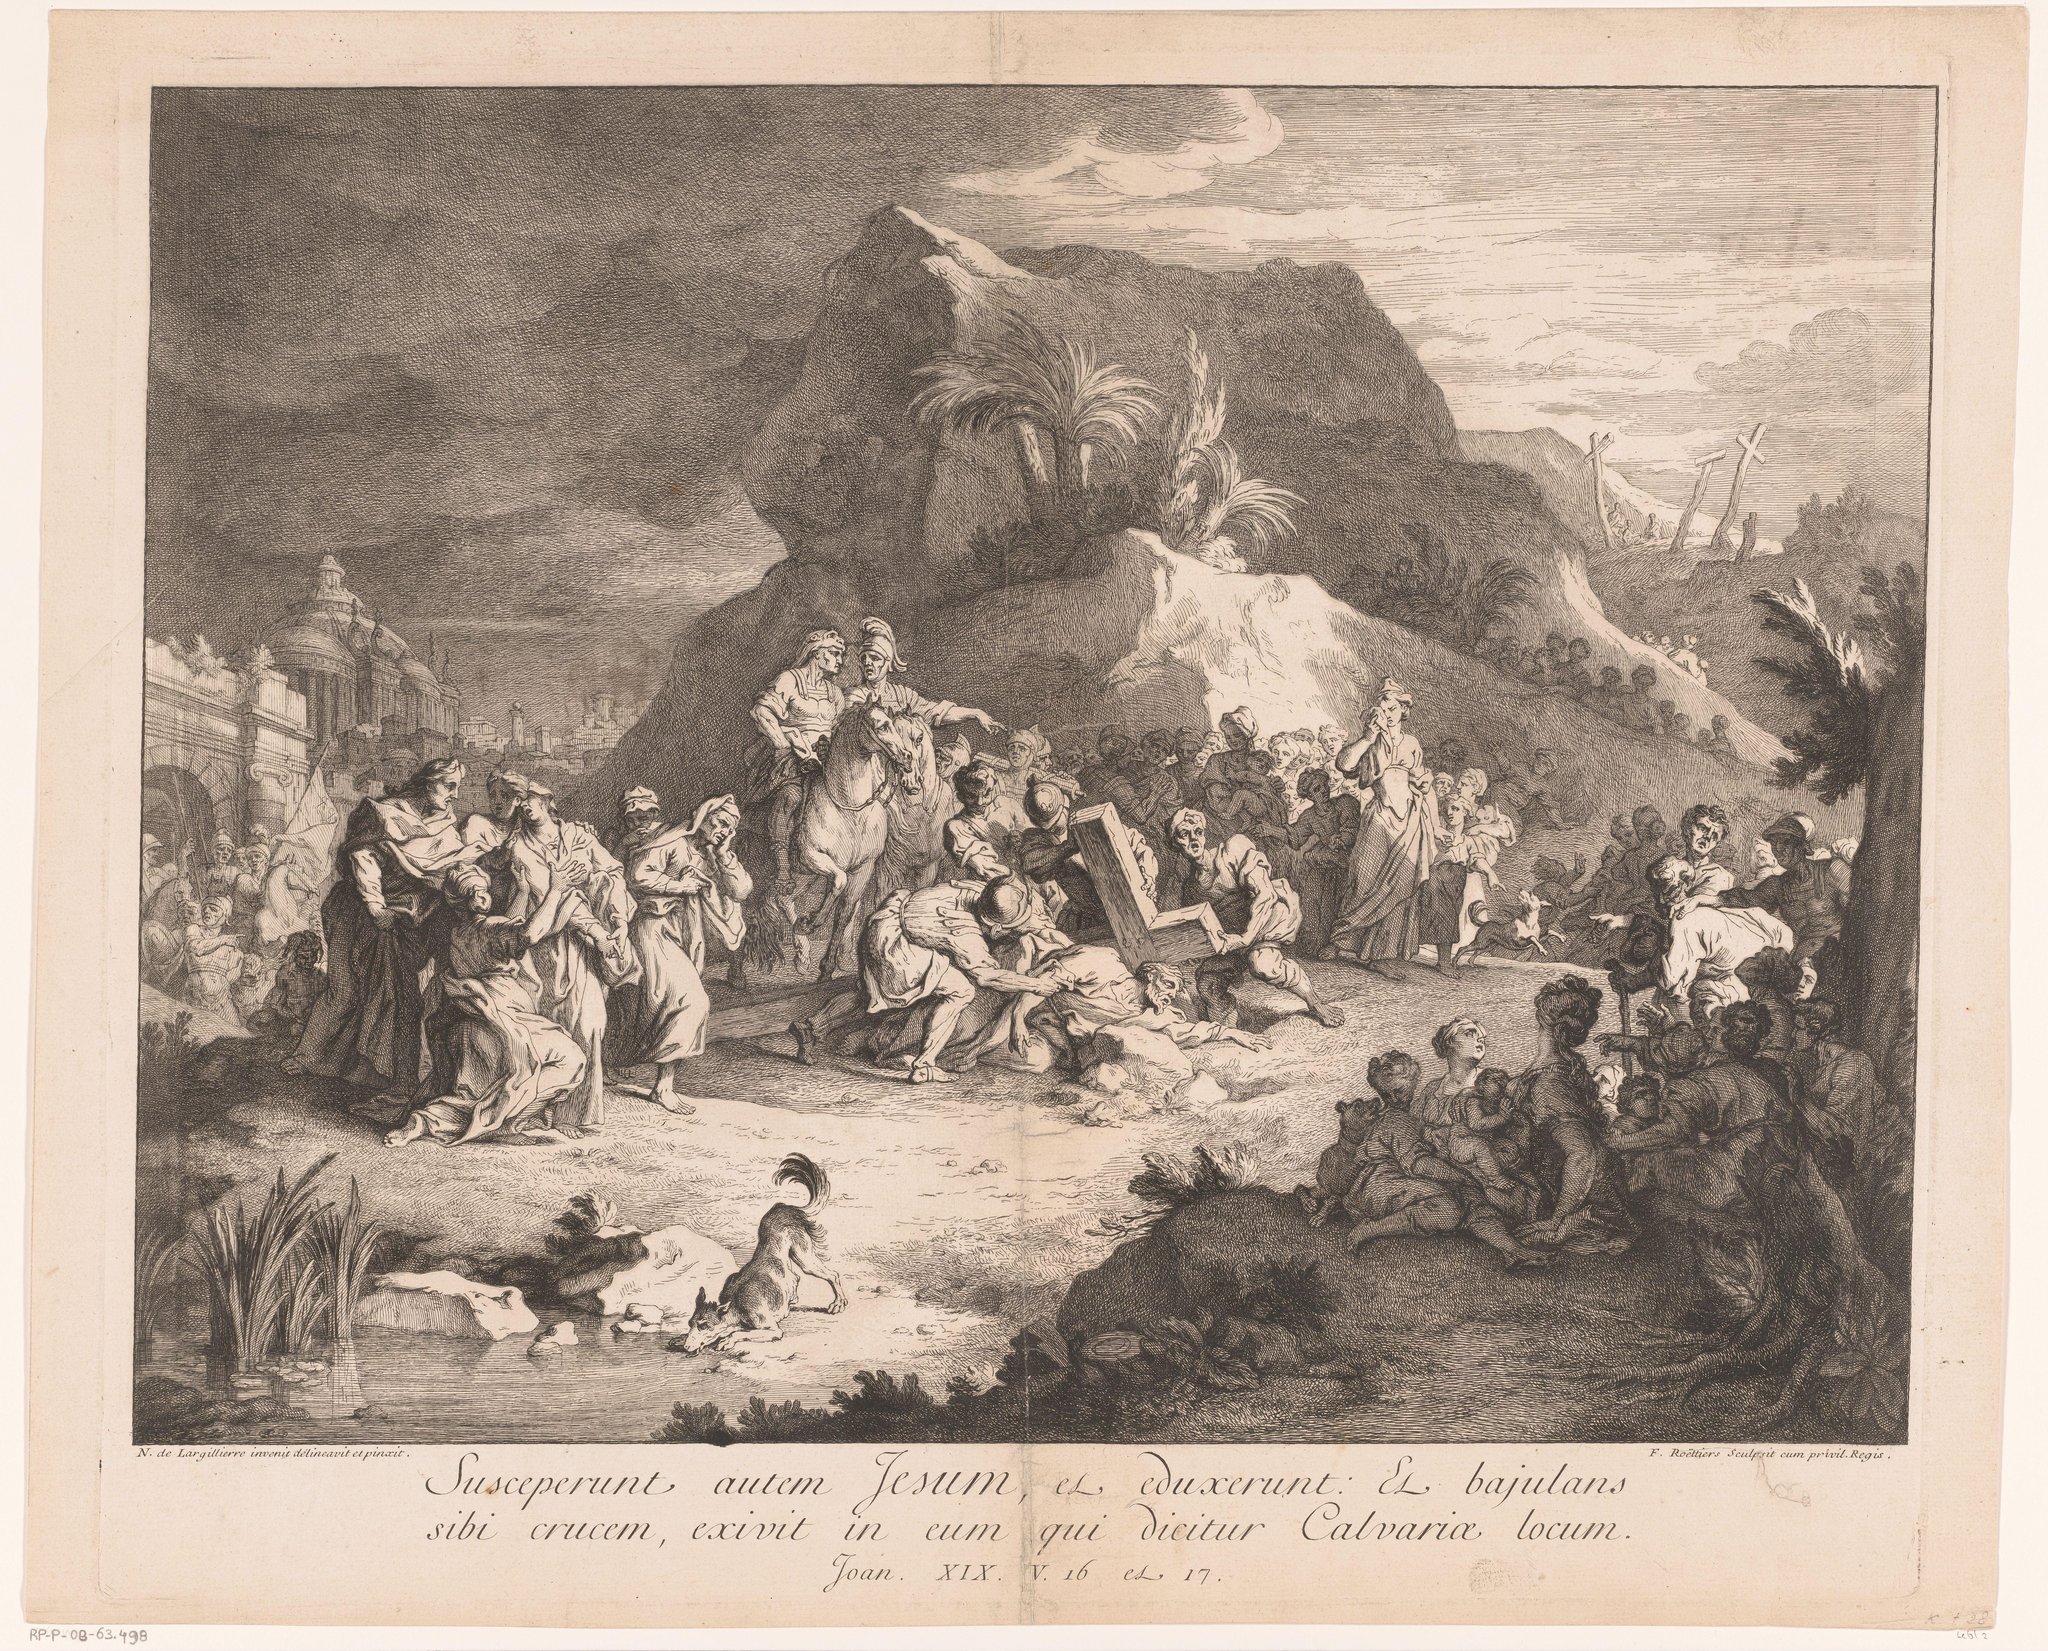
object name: print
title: Kruisdraging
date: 1717-1770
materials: paper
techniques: etching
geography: france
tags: christ collapsing ~ carrying of the cross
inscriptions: collector's mark: Lugt 240